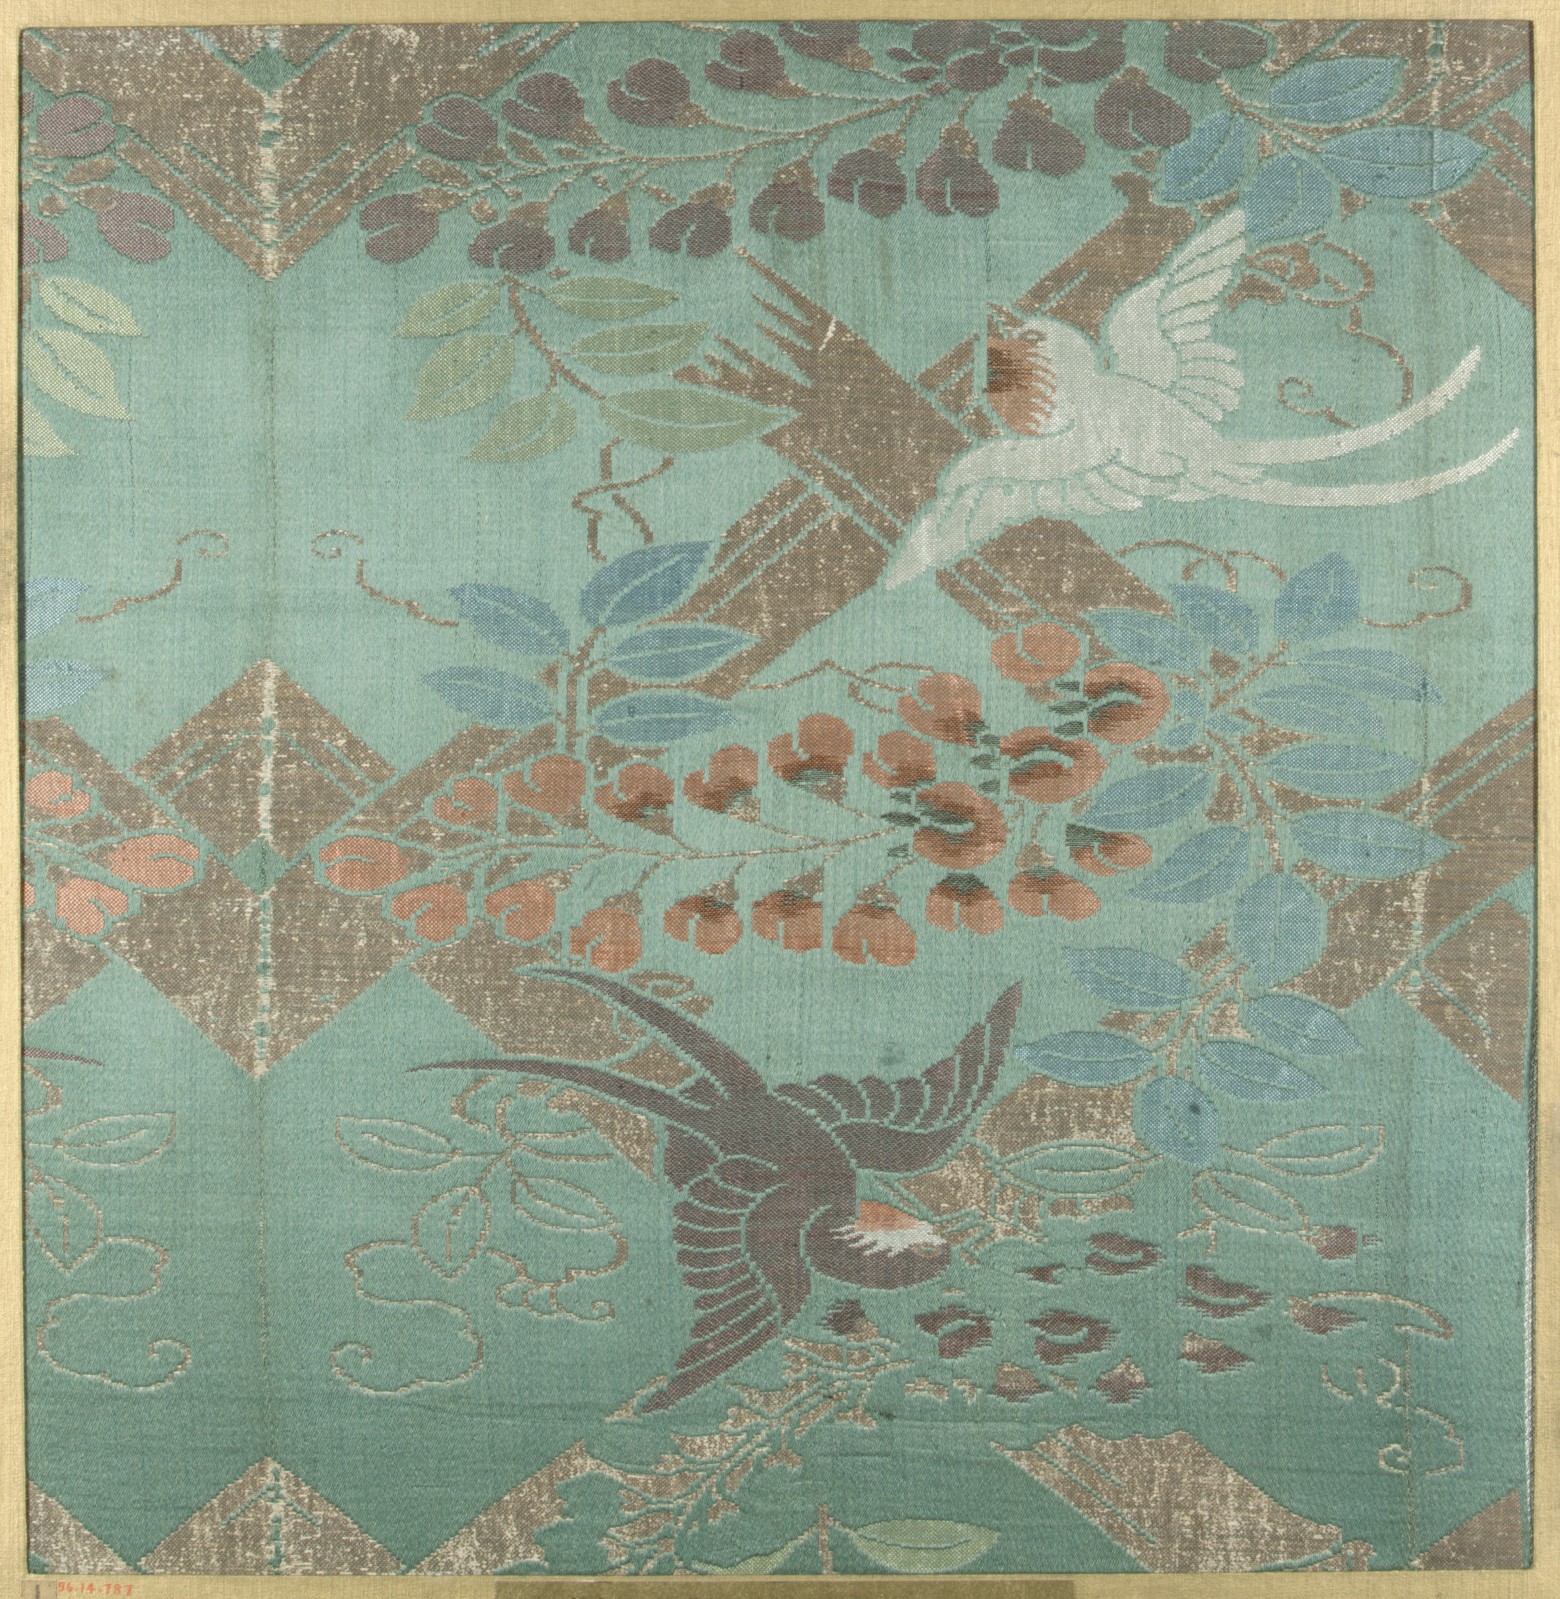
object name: piece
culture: japanese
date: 1701-1900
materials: silk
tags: birds